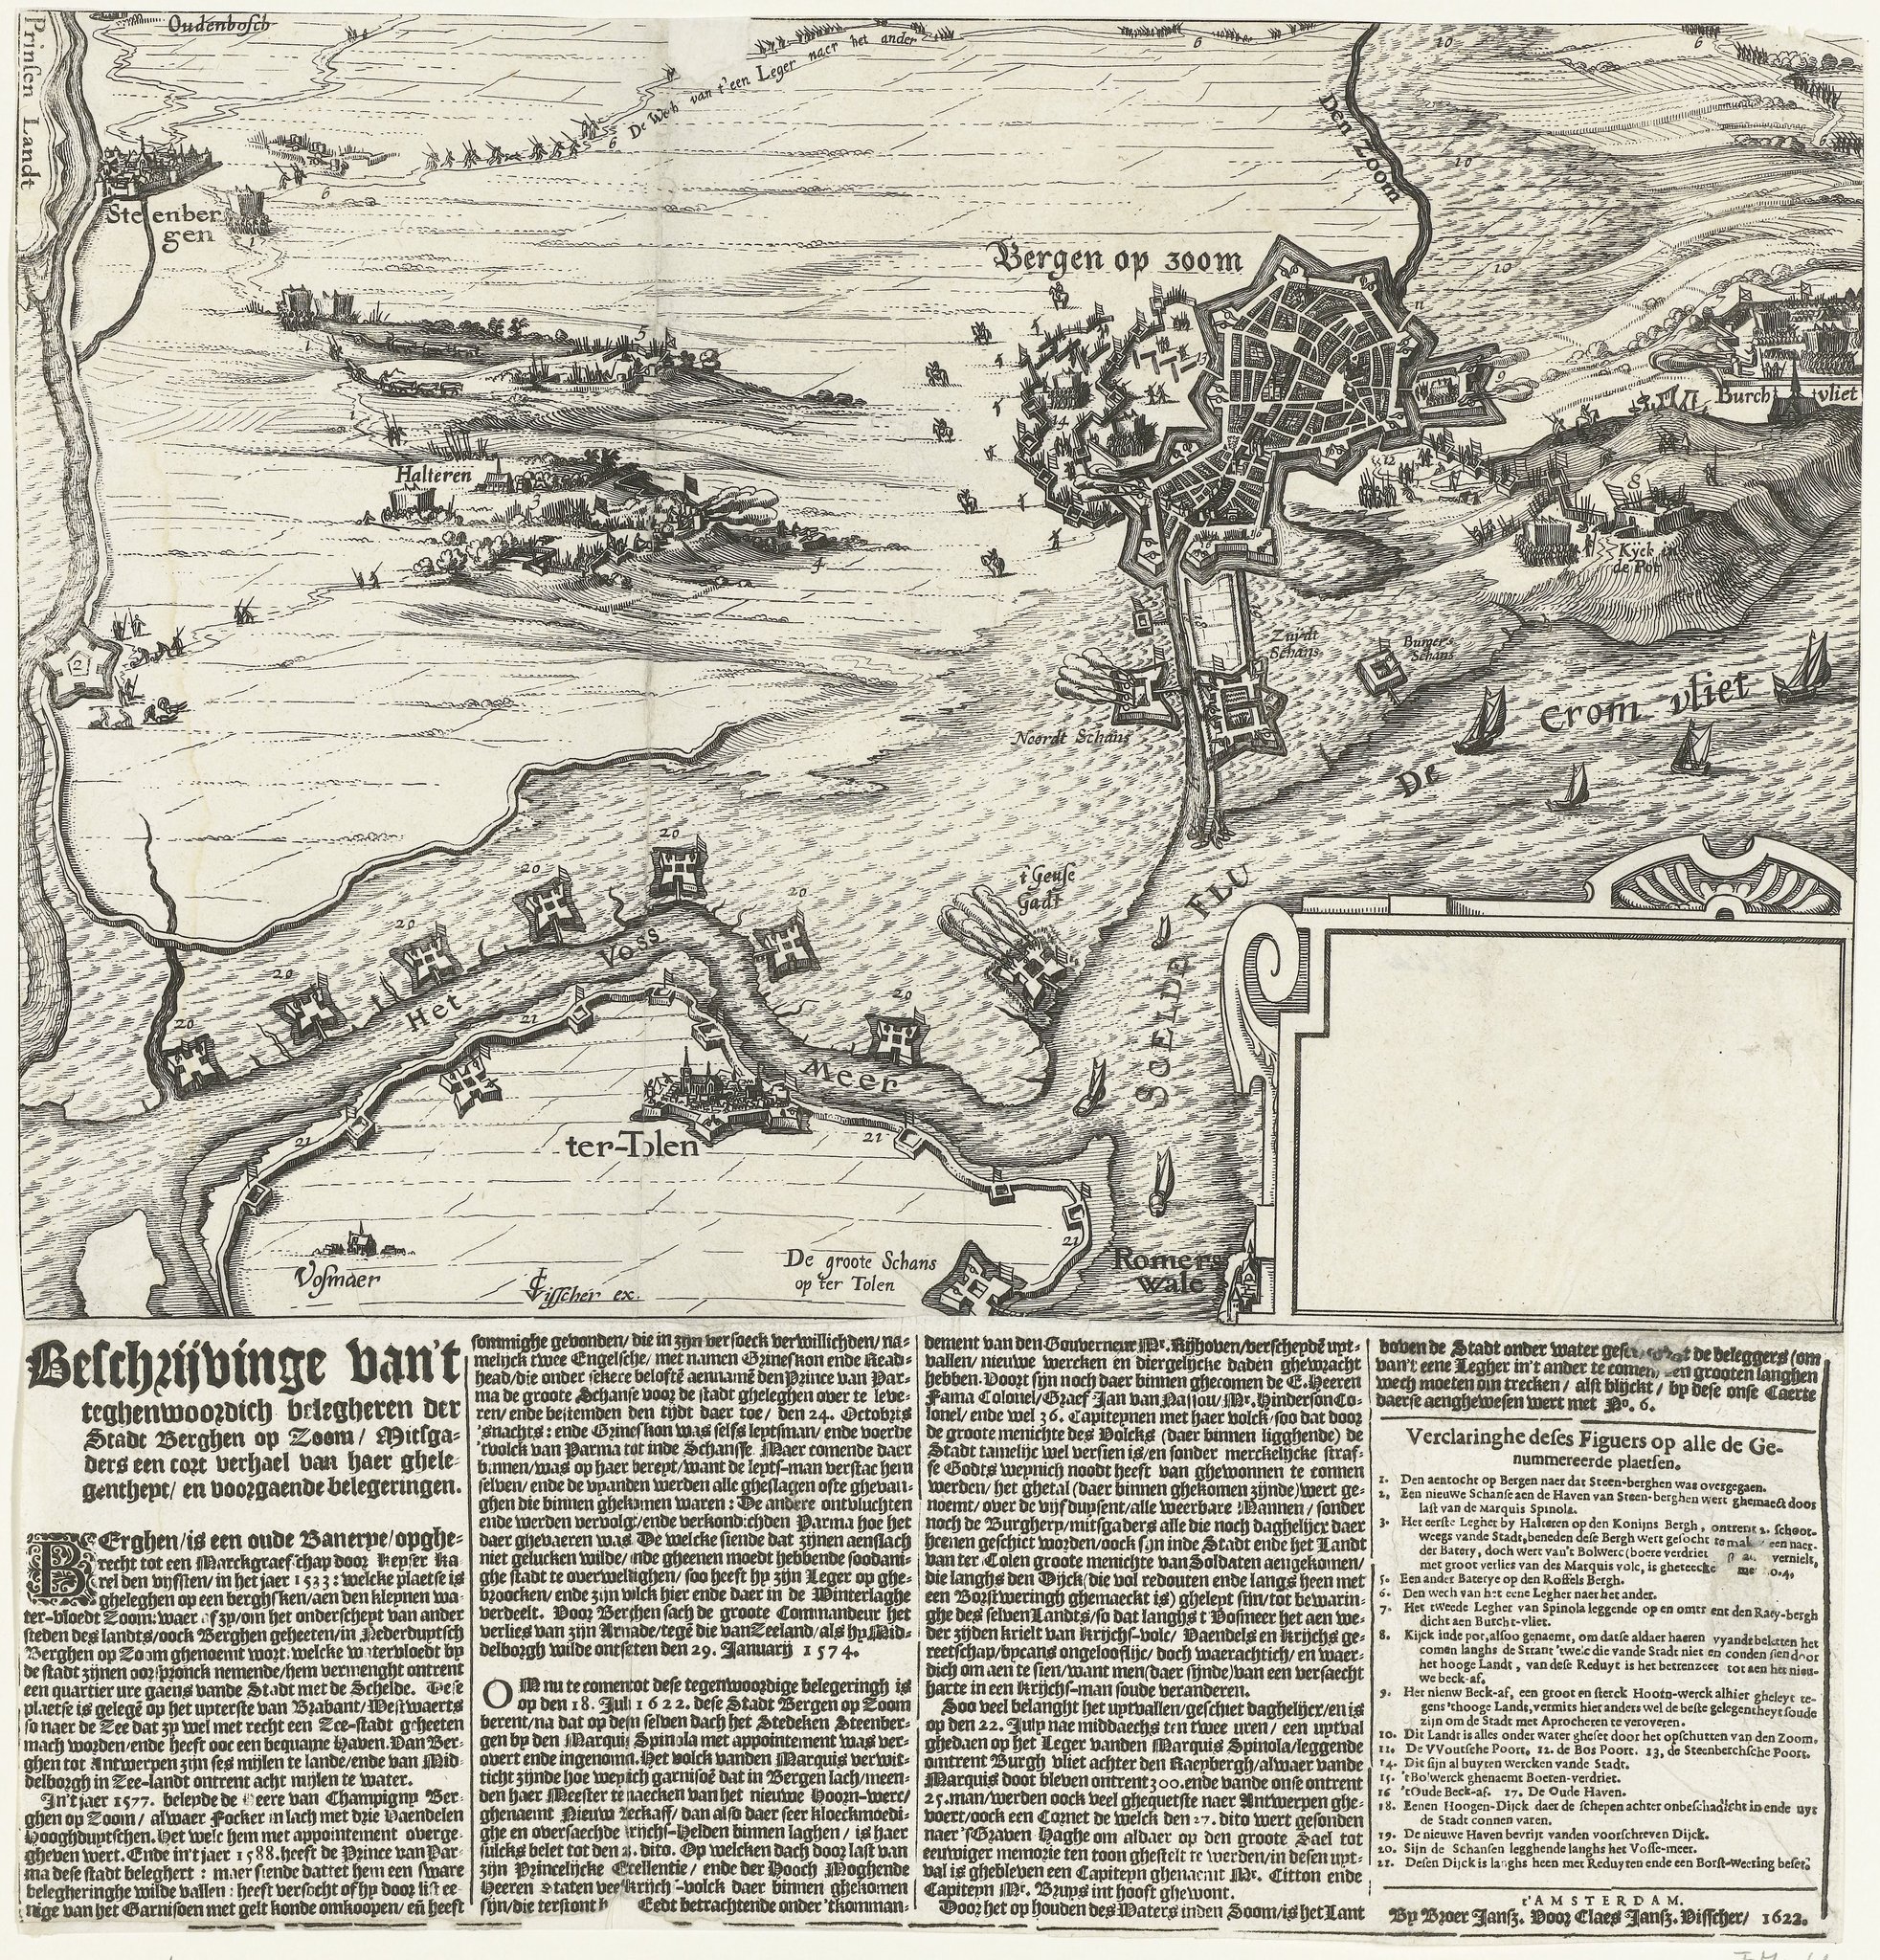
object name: print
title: Beschrijvinge van 't teghenwoordich belegheren der Stadt Berghen op Zoom / Mitsgaders een cort verhael van haer ghelegenheyt / en voorgaende belegeringen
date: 1622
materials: paper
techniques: etching, letterpress printing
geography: amsterdam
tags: siege, position war, bergen op zoom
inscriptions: date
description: Mislukt beleg van Bergen op Zoom door het Spaanse leger onder Spinola en Velasco, 18 juli - 3 oktober 1622. Plan van de stad en omgeving met waterwegen. Rechtsonder een blanco cartouche. Onder de voorstelling geplakt een tekst in 4 kolommen met een beschrijving van het beleg en de legenda 1-21 in het Nederlands.